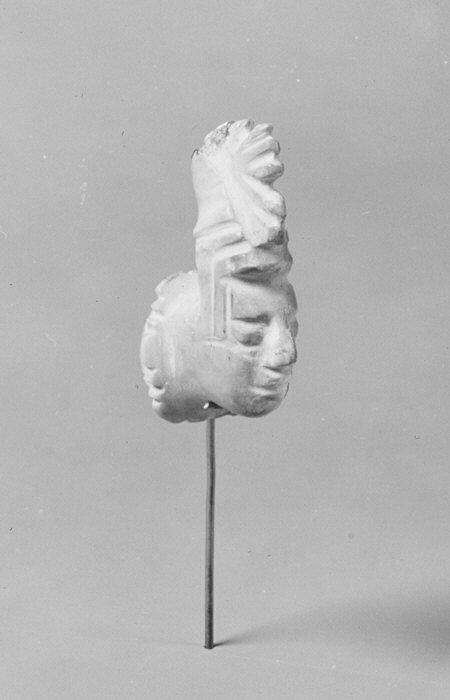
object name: pendant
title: Head Pendant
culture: maya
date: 601-800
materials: shell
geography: mexico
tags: heads